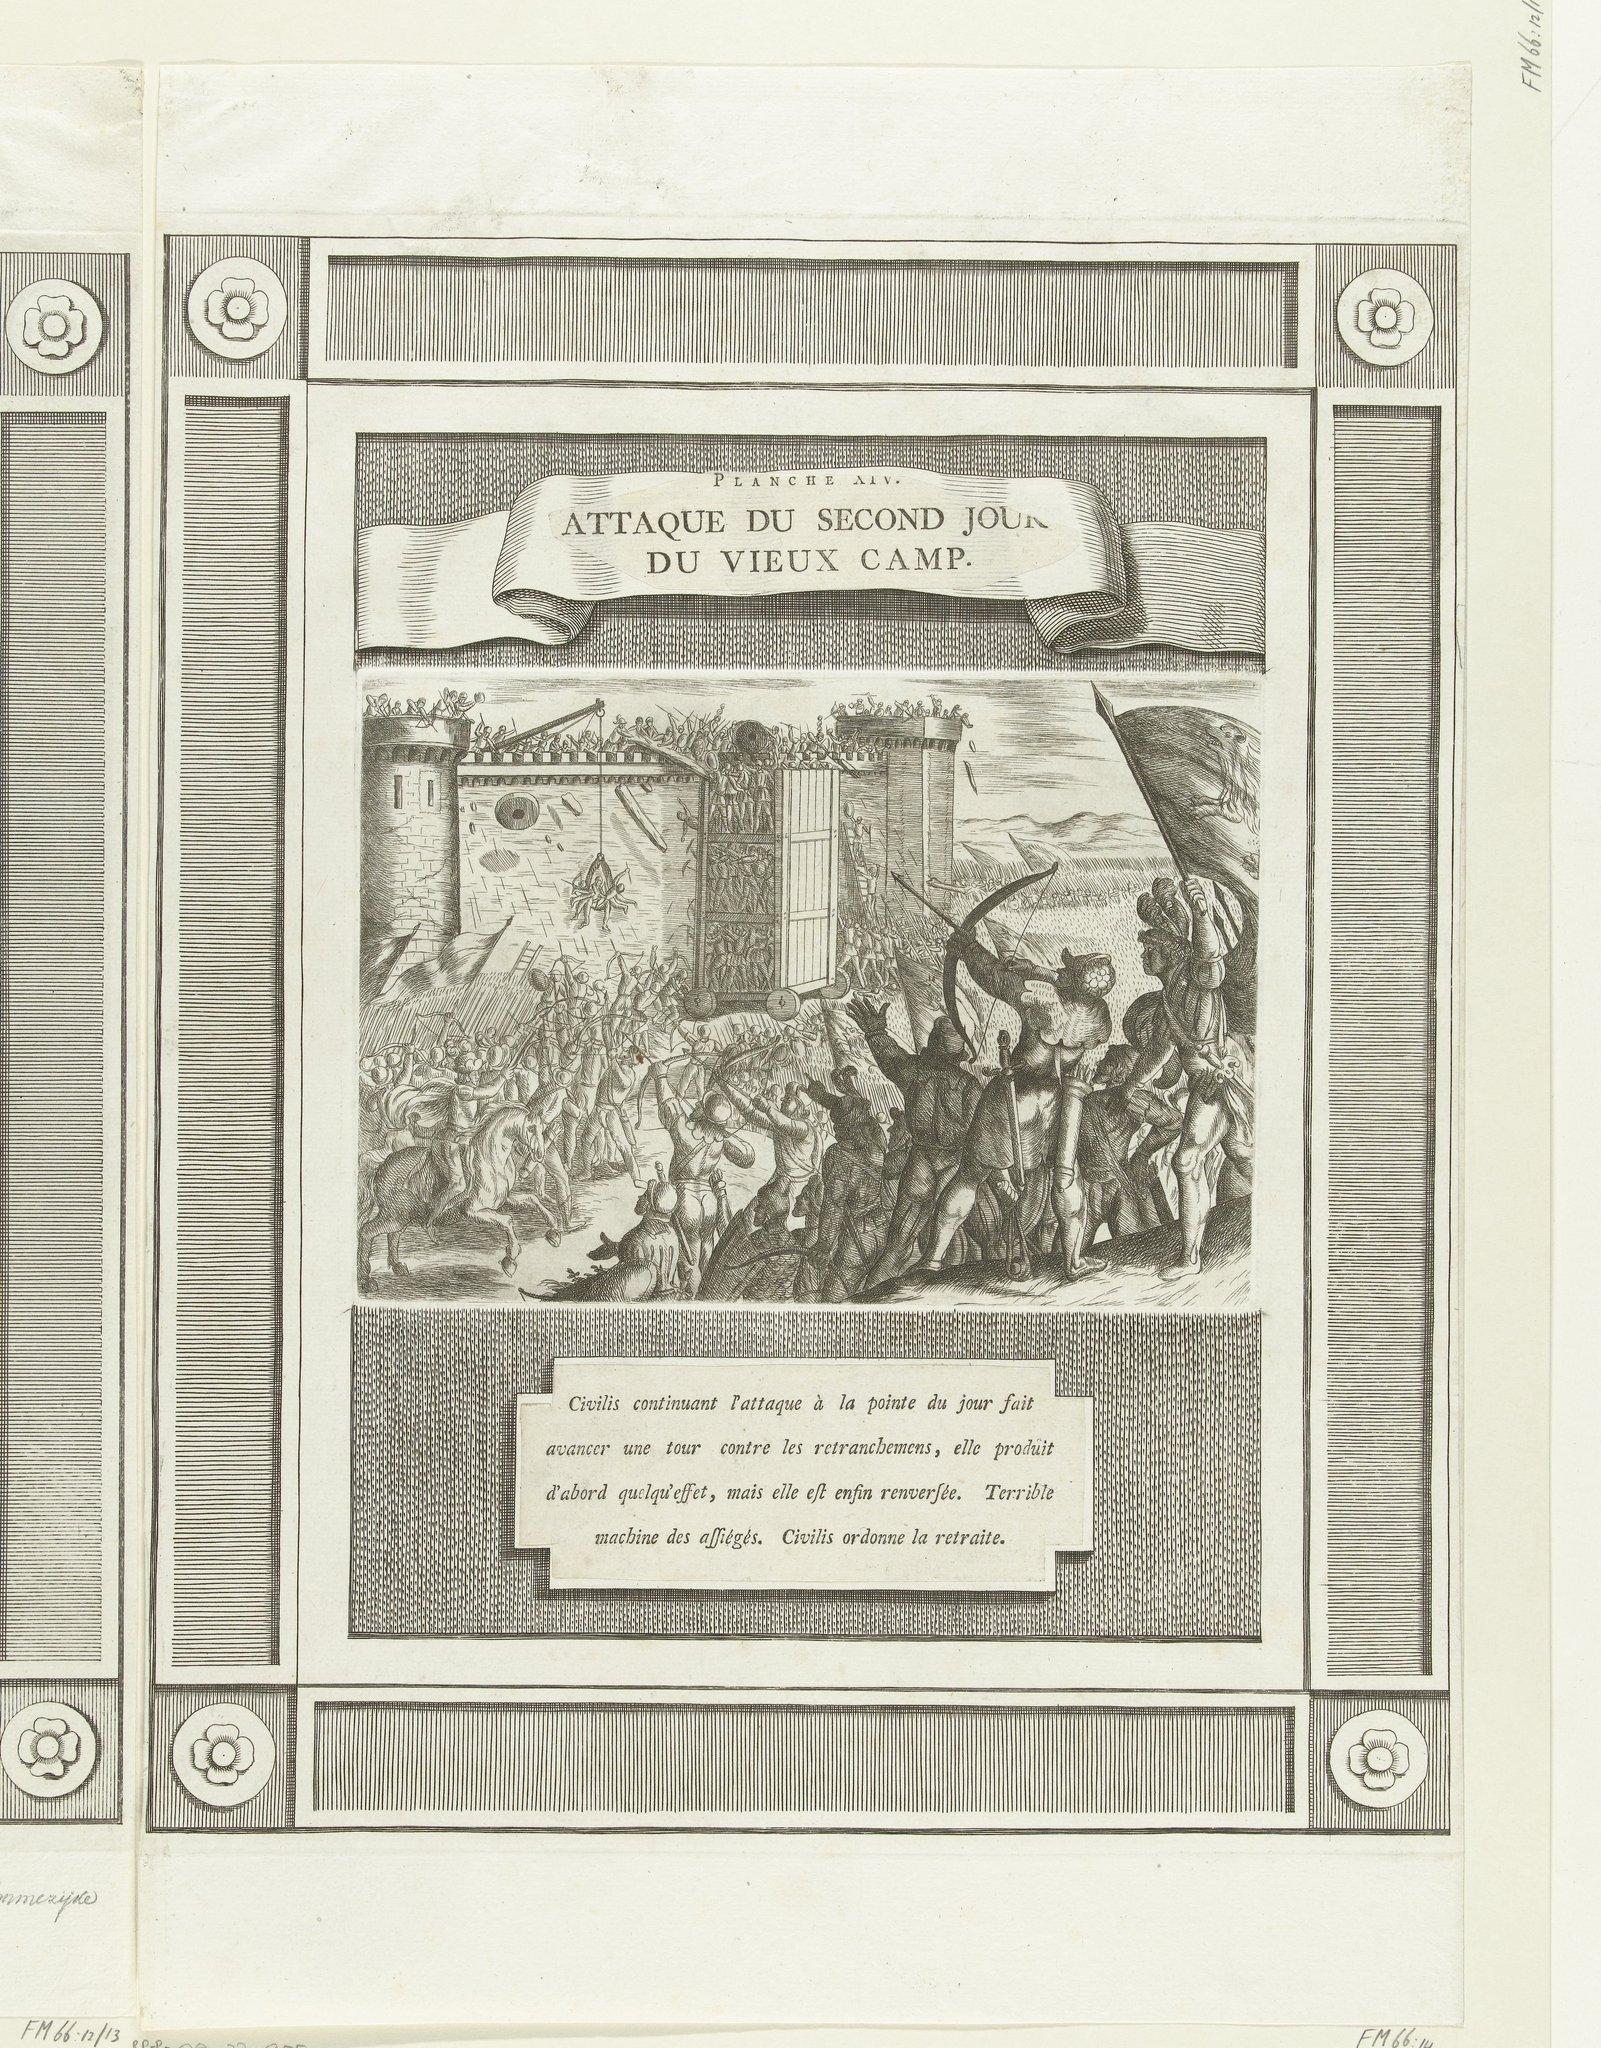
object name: print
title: Nieuwe aanval op een Romeinse vesting, 69-70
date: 1768-1770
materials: paper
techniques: engraving, etching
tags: battle, fighting in general, extinct, 'historical' peoples (with name), netherlands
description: Een nieuwe aanval op een Romeinse vesting waarbij gebruik wordt gemaakt van een houten toren. Prent 14 in een serie over de Bataafse Opstand, gekopieerd naar de reeks Batavorum cum Romanis bellum van Antonio Tempesta (Otto Vaenius, Antwerpen 1612). Illustratie voor: Marquis de St. Simon, Histoire de la guerre des Bataves et des Romains, d'après César; Corneille Tacite, Aux dépens de Marc-Michel Rey, Amsterdam 1770. Voorstellingen gedrukt in een grote ornamentele omlijsting waarin bovenaan een uitgeknipte titel en onderaan een onderschrift in het Frans is geplakt. Gedrukt op de achterkant van planche XII.